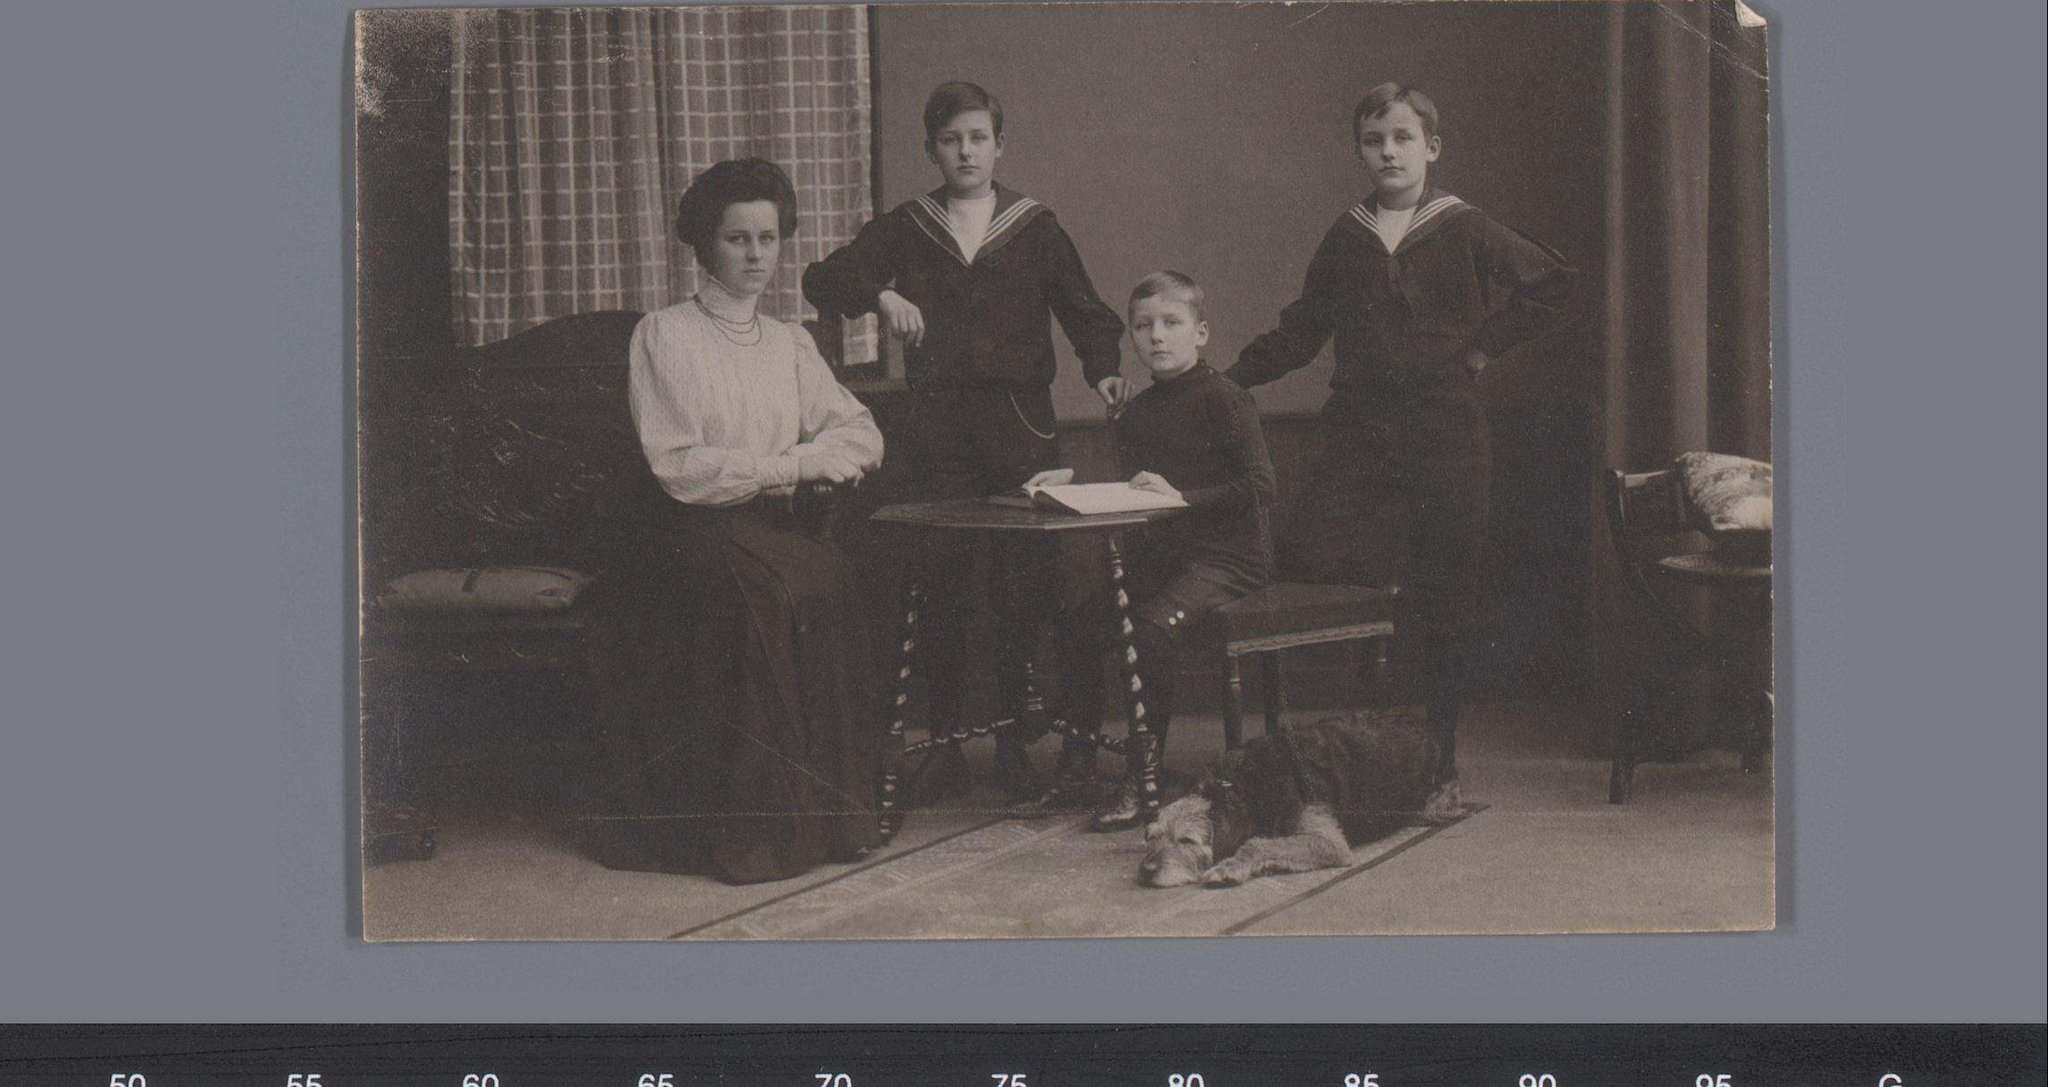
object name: photograph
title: Groepsportret van Johanna Geertruida, Lucas, Willem en Goverdus Henricus Jonker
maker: verschuur (fotograaf)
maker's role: fotograaf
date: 1910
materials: photographic support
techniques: gelatin silver print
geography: bussum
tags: historical persons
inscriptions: annotation: ‘±1910’